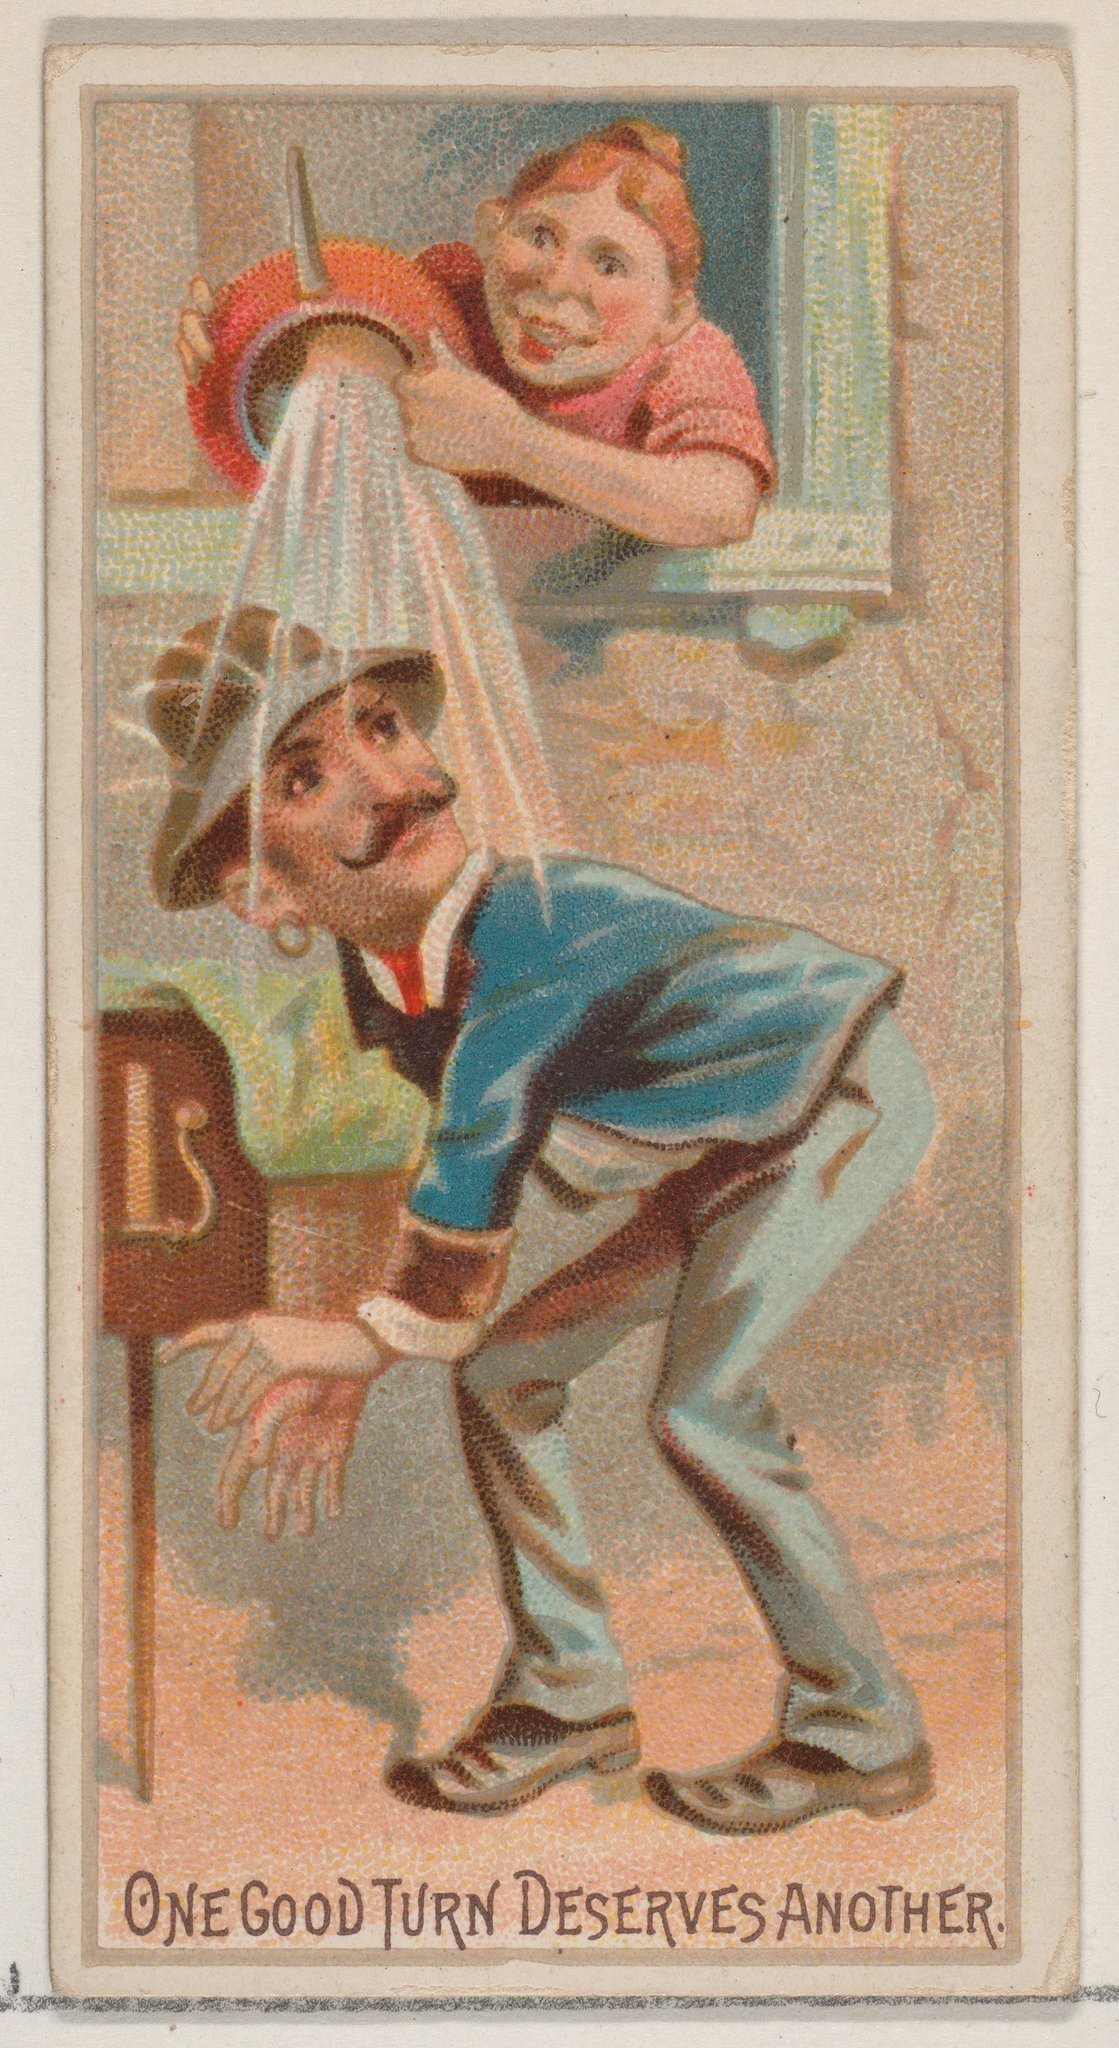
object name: print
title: One Good Turn Deserves Another, from the Jokes series (N87) for Duke brand cigarettes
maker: w. duke, sons & co.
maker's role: publisher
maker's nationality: american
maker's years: 1870-1920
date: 1890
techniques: color lithograph